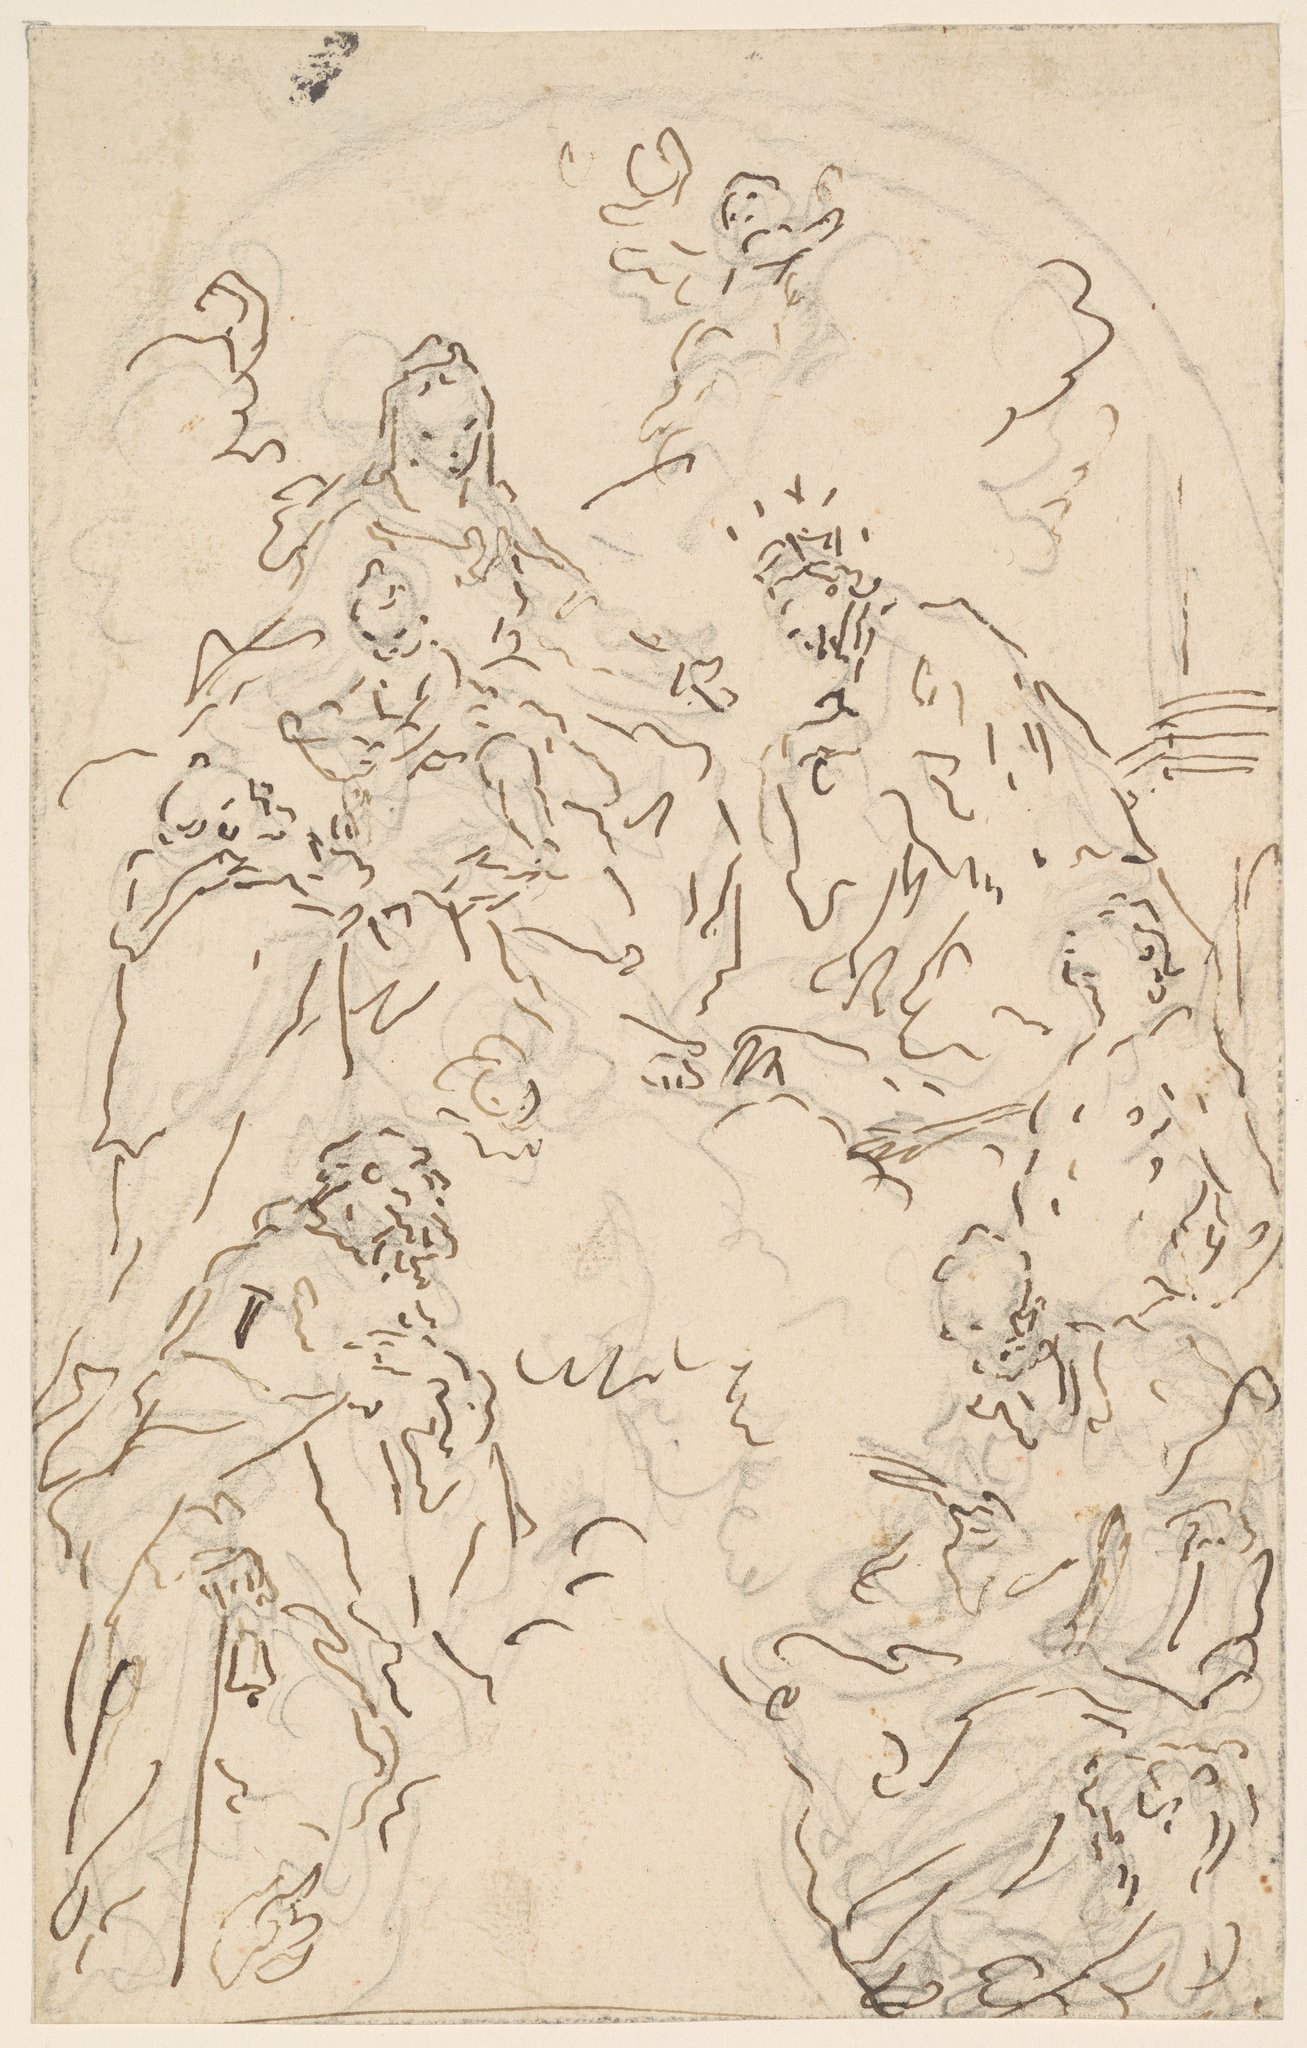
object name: drawing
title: The Virgin and Child Enthroned on a Cloud, with Saints Dominic, John Nepomuk, Sebastian, Mark, and Anthony Abbot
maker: giuseppe diziani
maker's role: artist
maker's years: 1732-1803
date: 1746-1771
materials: chalk, ink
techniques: pen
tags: madonna and child,saints